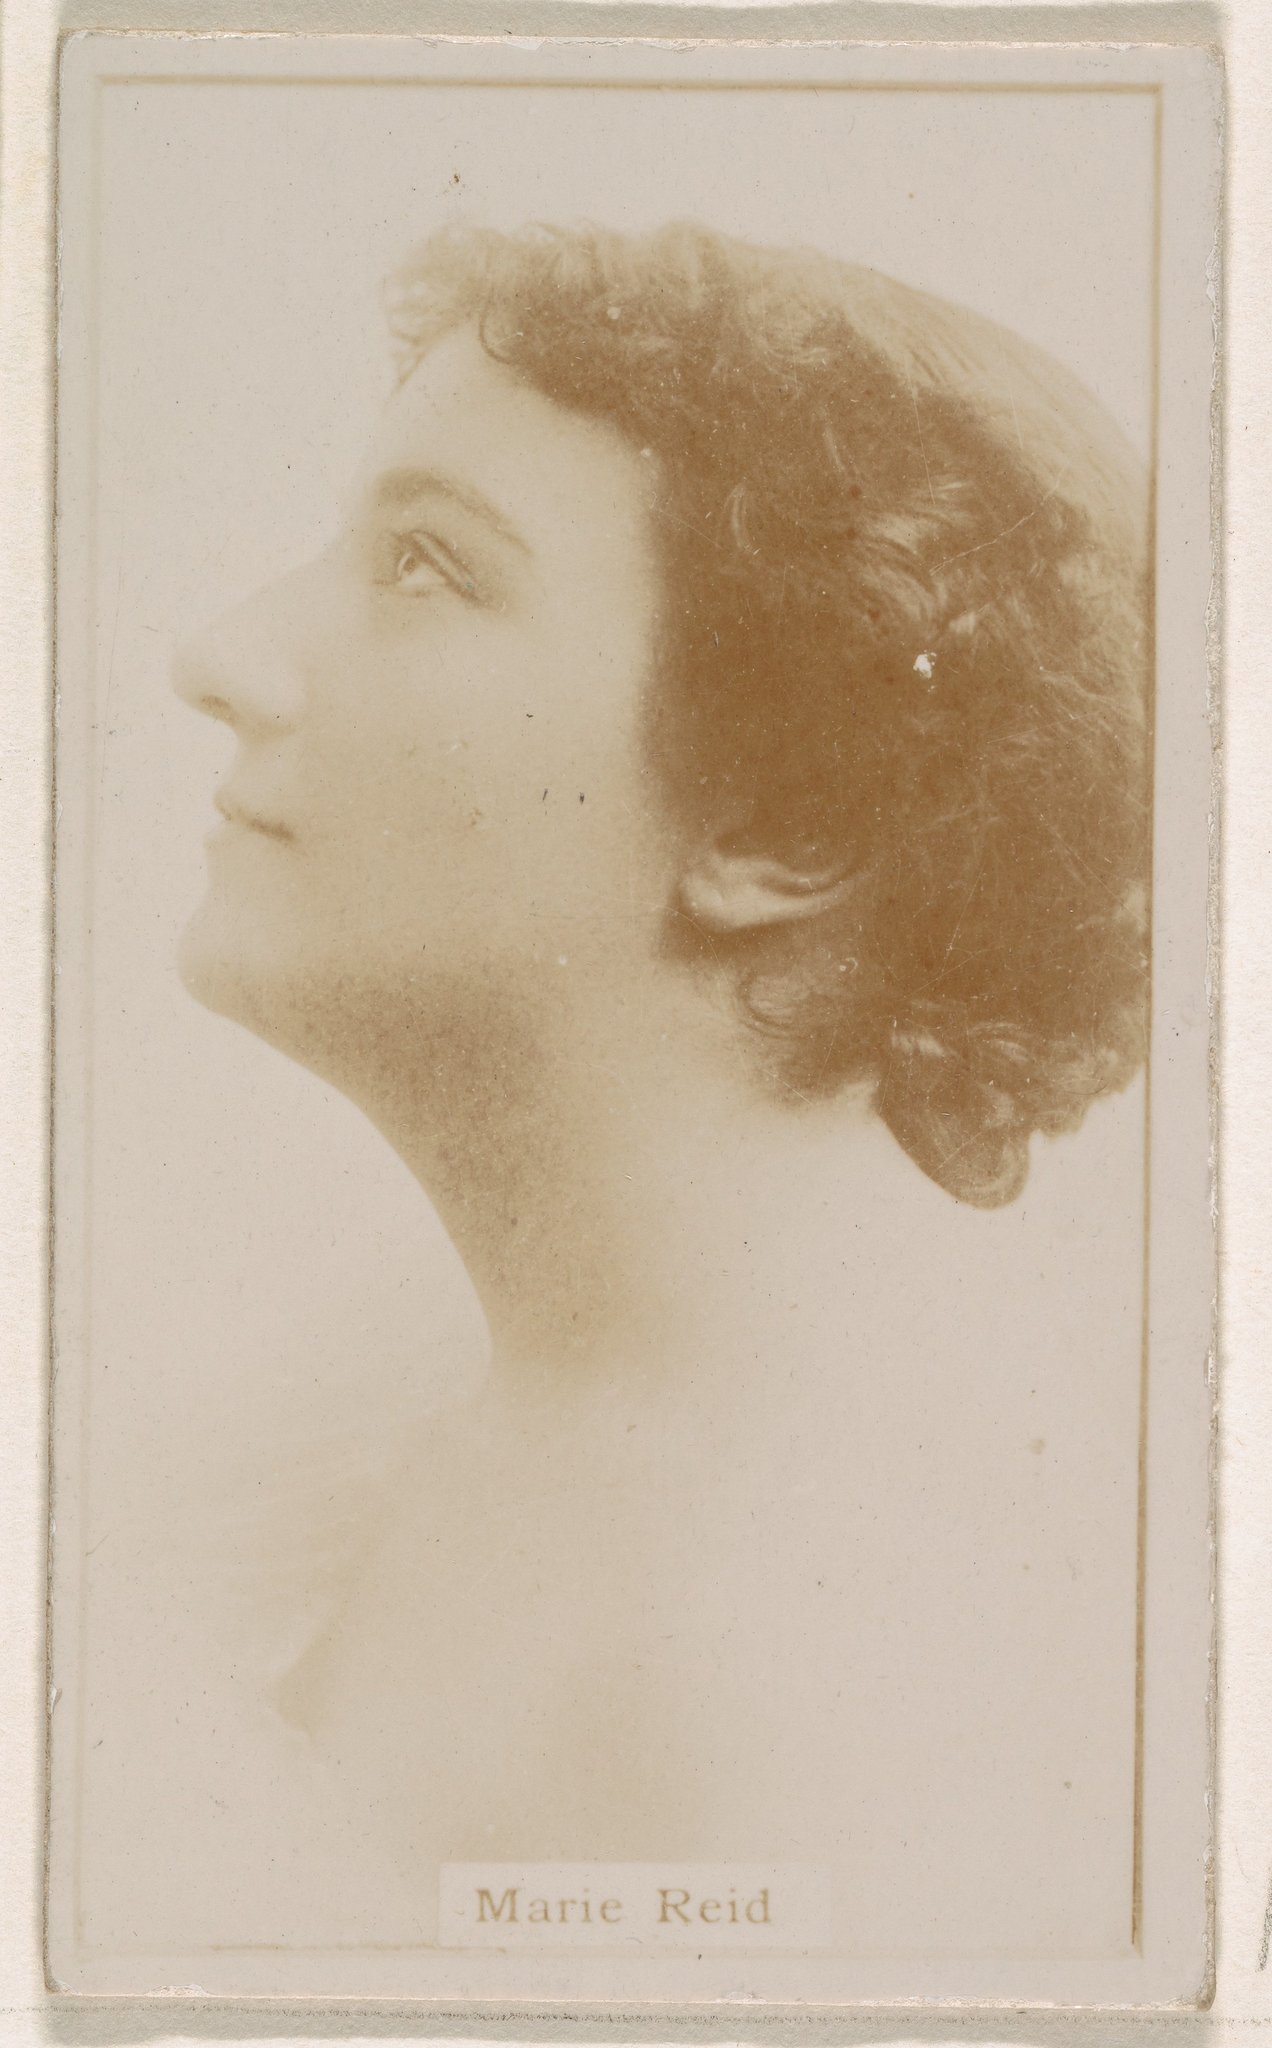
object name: photograph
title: Marie Reid, from the Actresses series (N245) issued by Kinney Brothers to promote Sweet Caporal Cigarettes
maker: kinney brothers tobacco company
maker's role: publisher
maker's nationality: american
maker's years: 1869-2011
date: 1890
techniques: albumen silver print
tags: women,actresses